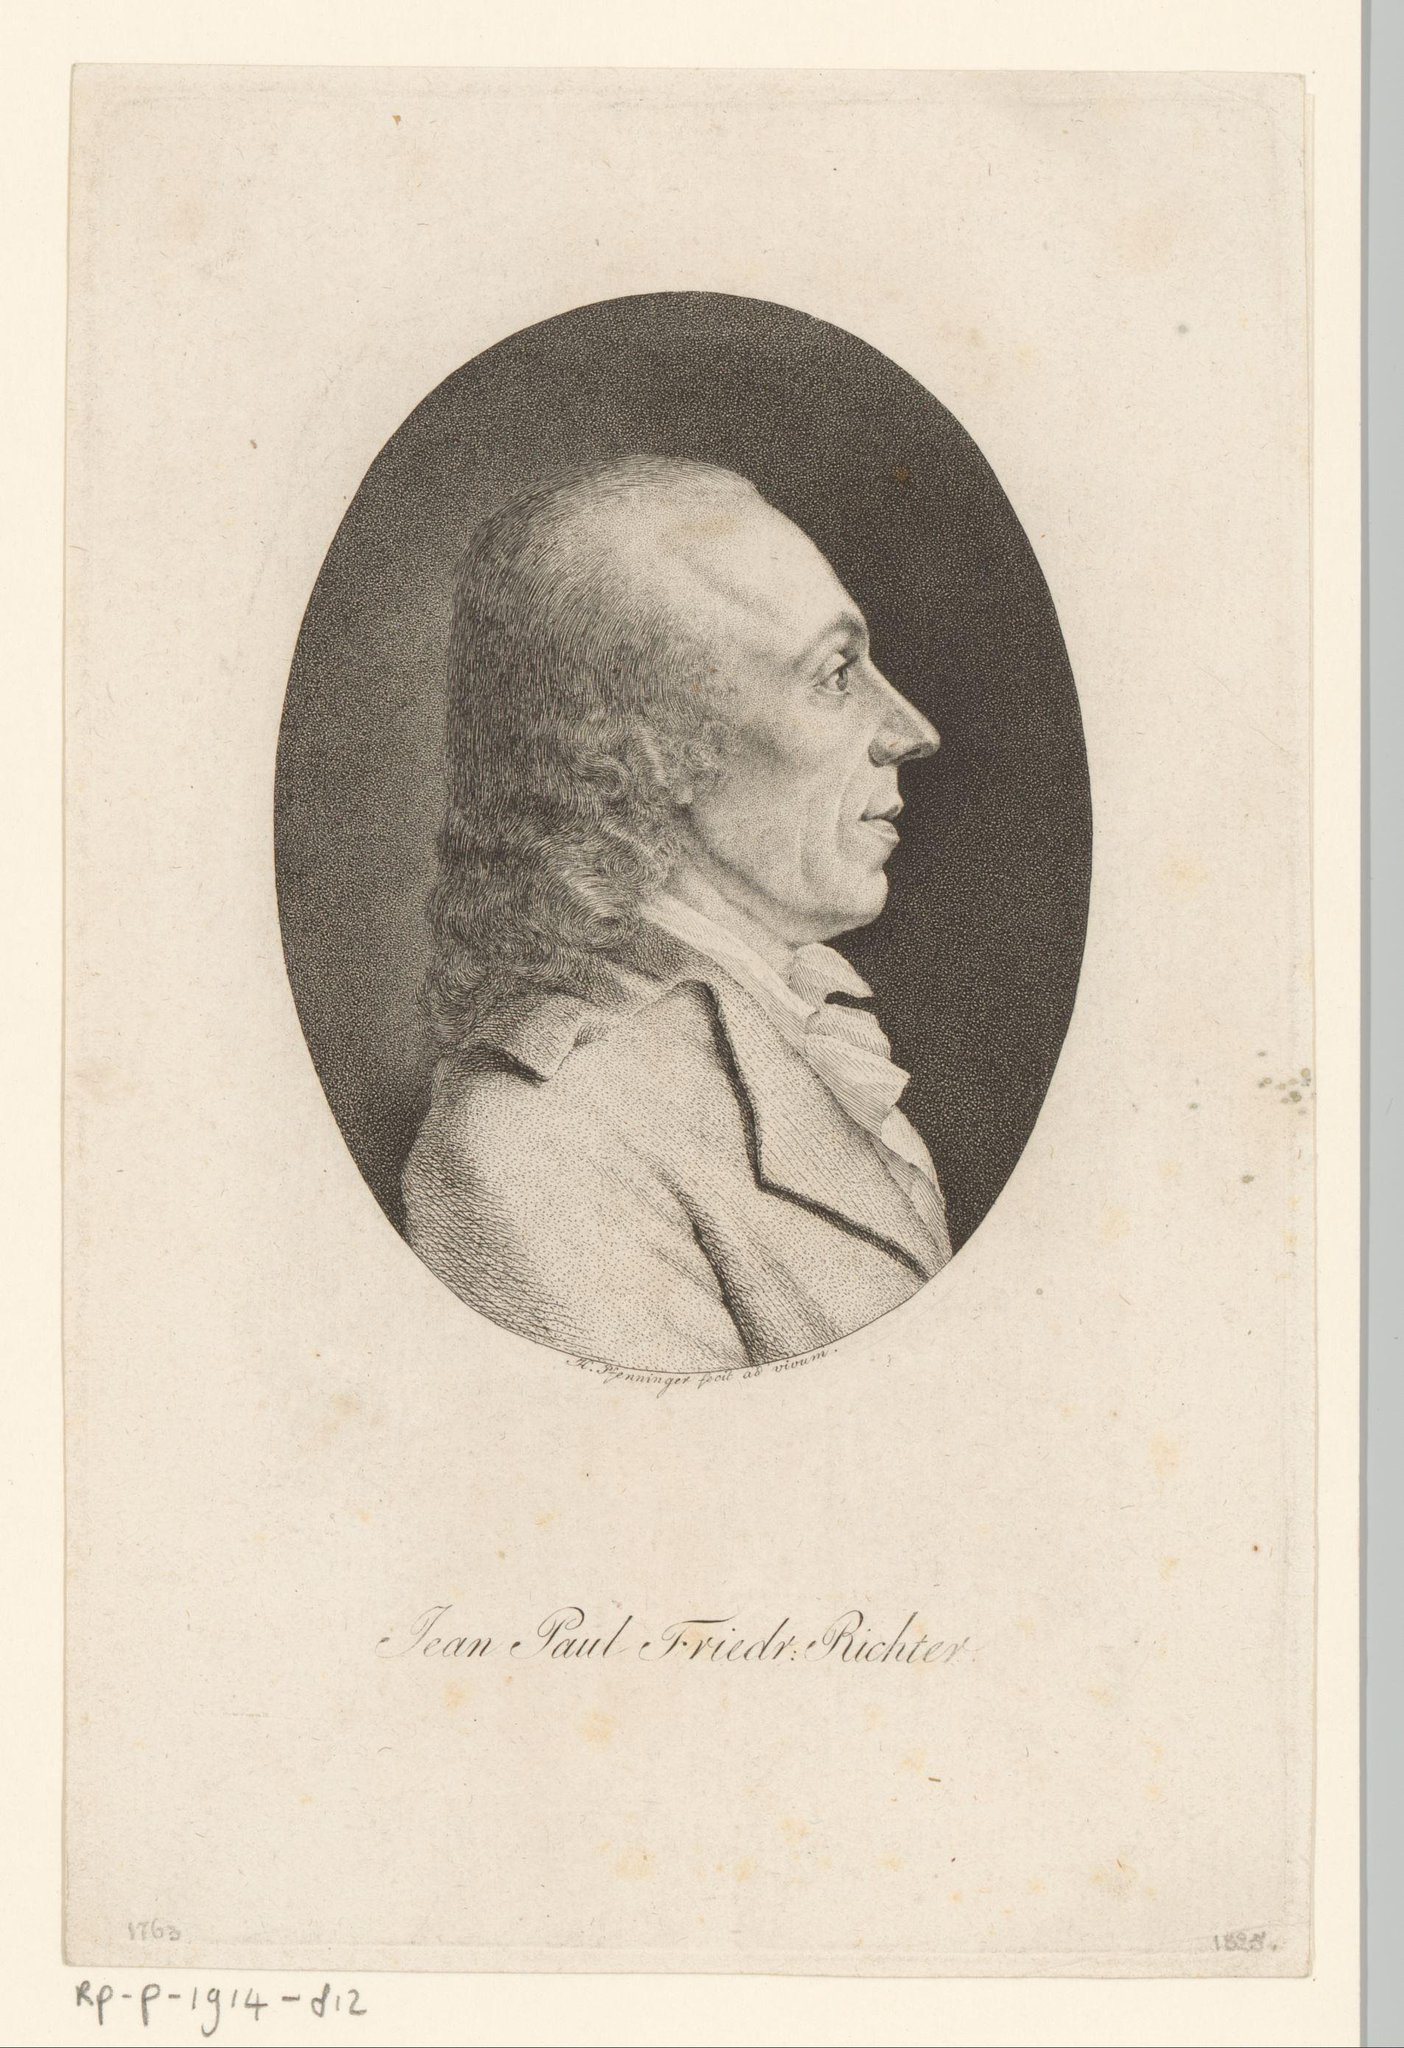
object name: print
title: Portret van Jean Paul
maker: heinrich pfenninger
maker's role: print maker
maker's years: 1749-1815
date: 1759-1815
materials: paper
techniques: etching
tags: jean paul, historical persons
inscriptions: number, collector's mark: Lugt 2228